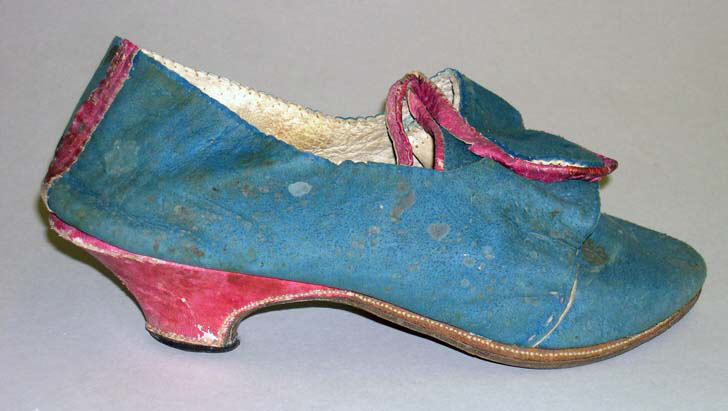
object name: shoe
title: Shoes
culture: italian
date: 1701-1800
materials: silk, wool